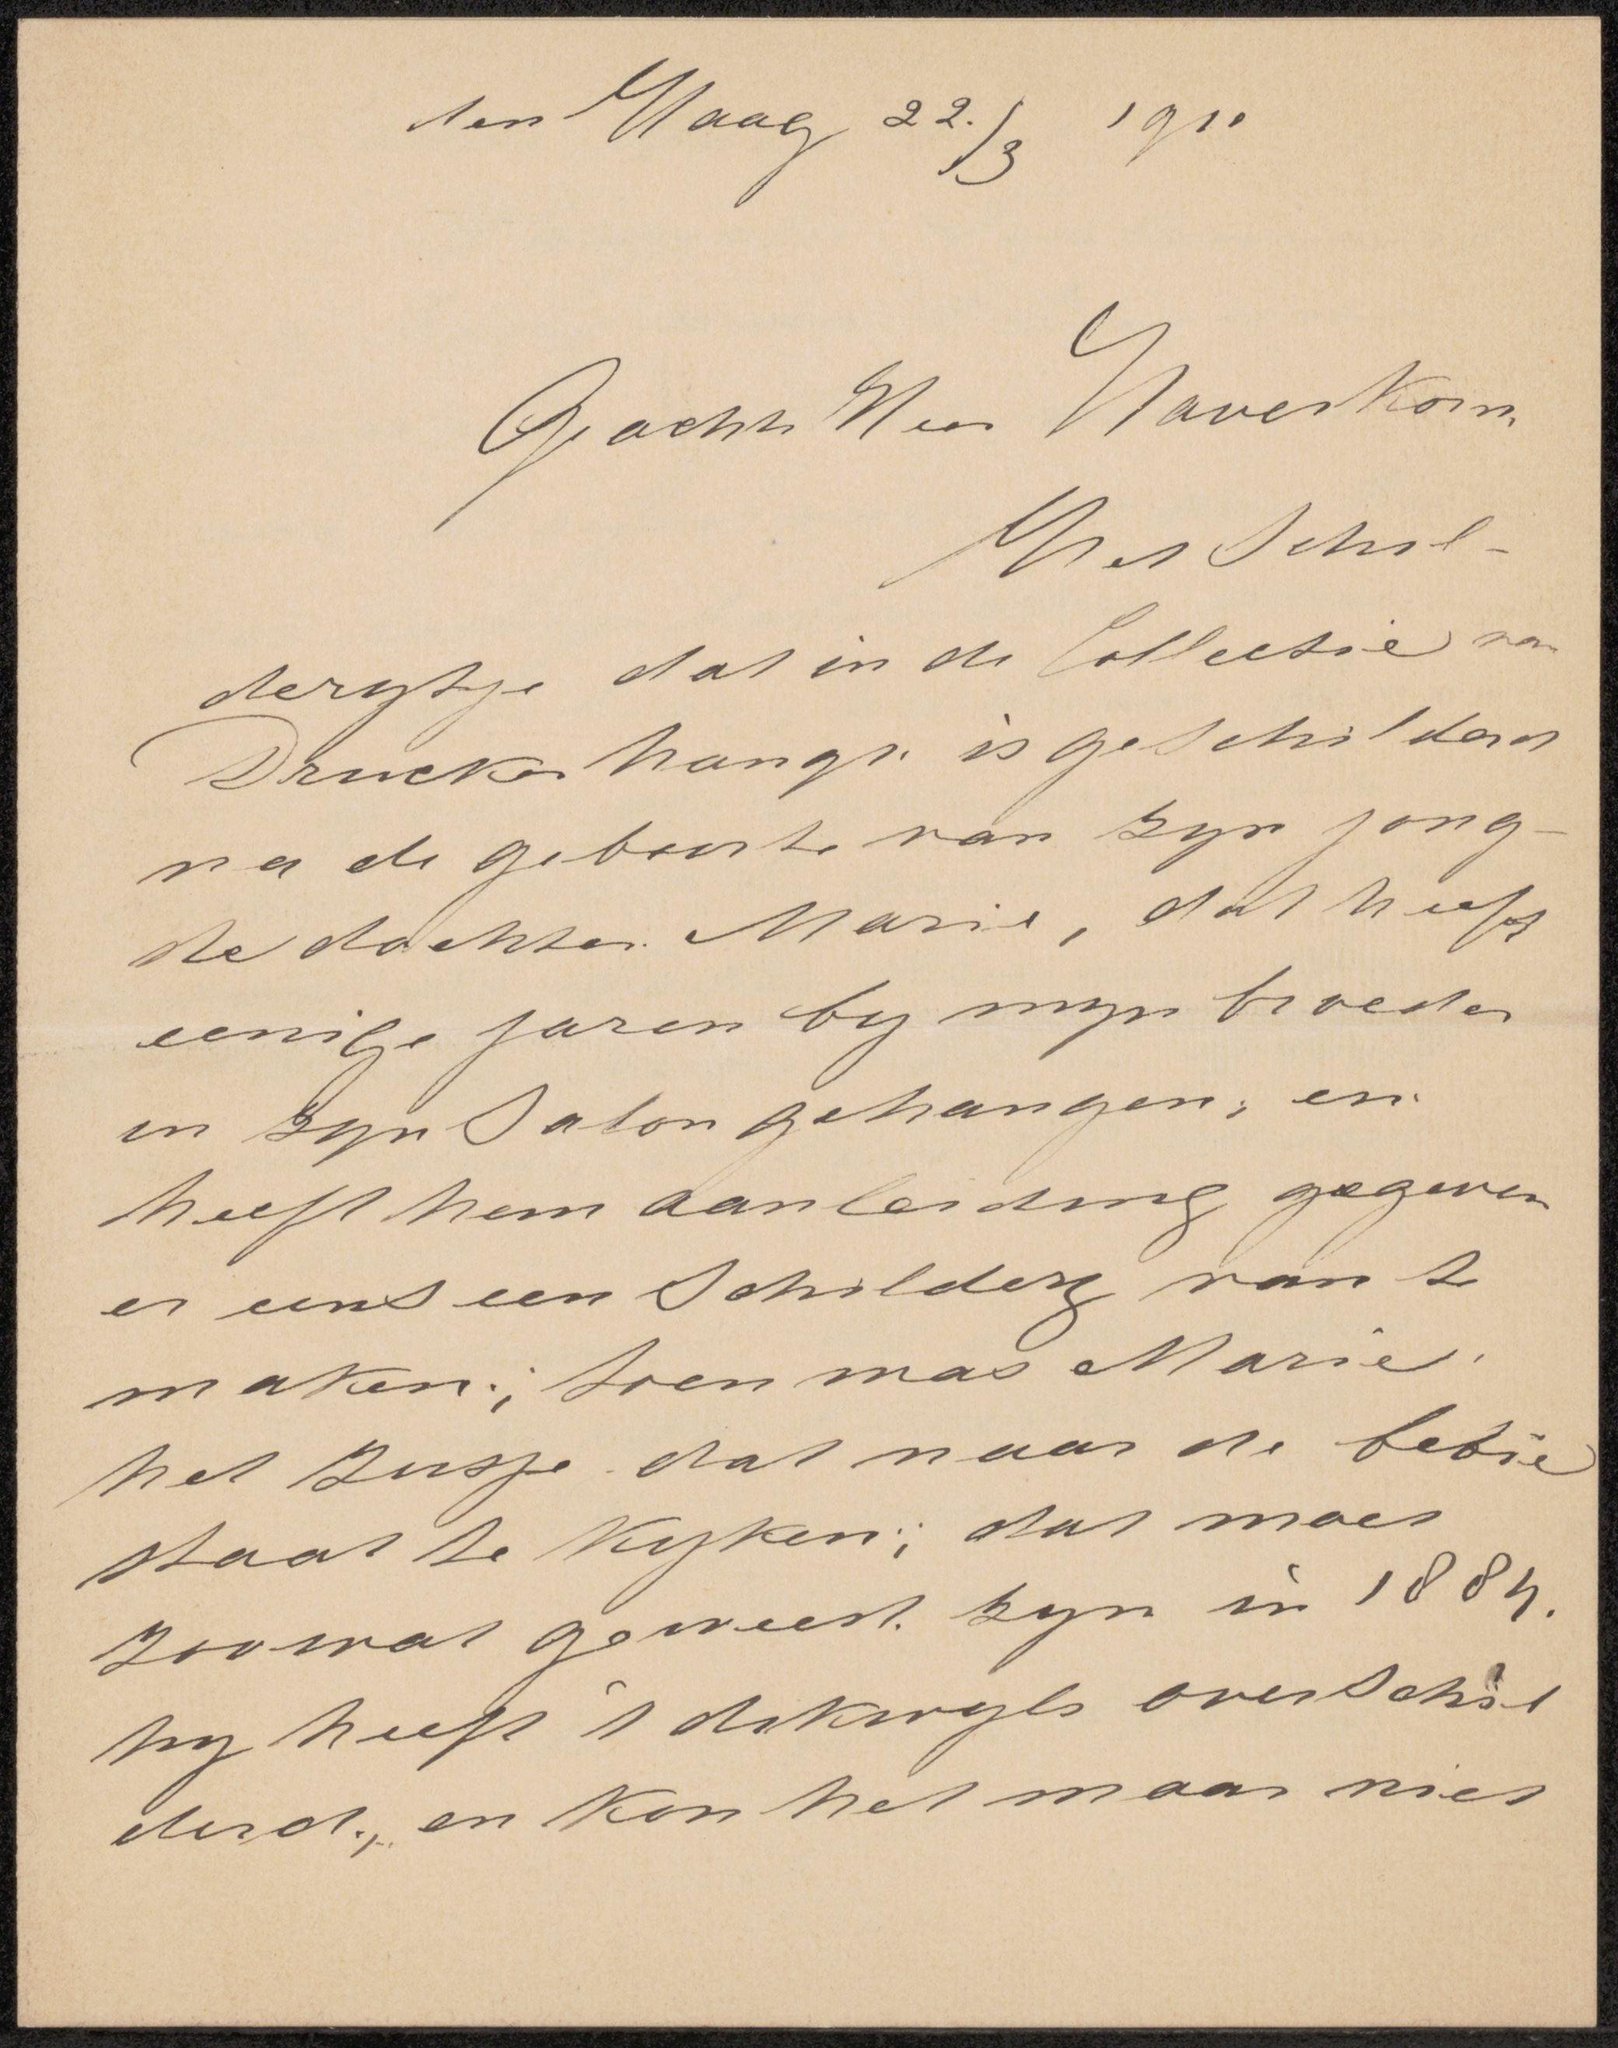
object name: letter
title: Brief aan Pieter Haverkorn van Rijsewijk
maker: willem maris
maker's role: draughtsman, painter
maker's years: 1844-1910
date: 1910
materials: ink, paper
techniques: pen, writing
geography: the hague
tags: the hague, painter, print maker, draughtsman, jacob maris, pieter haverkorn van rijsewijk, artist's model, sitter, painting (including book-illumination, miniature-painting), workshop, studio of the artist (in general), exhibition ~ art, art collecting, paris